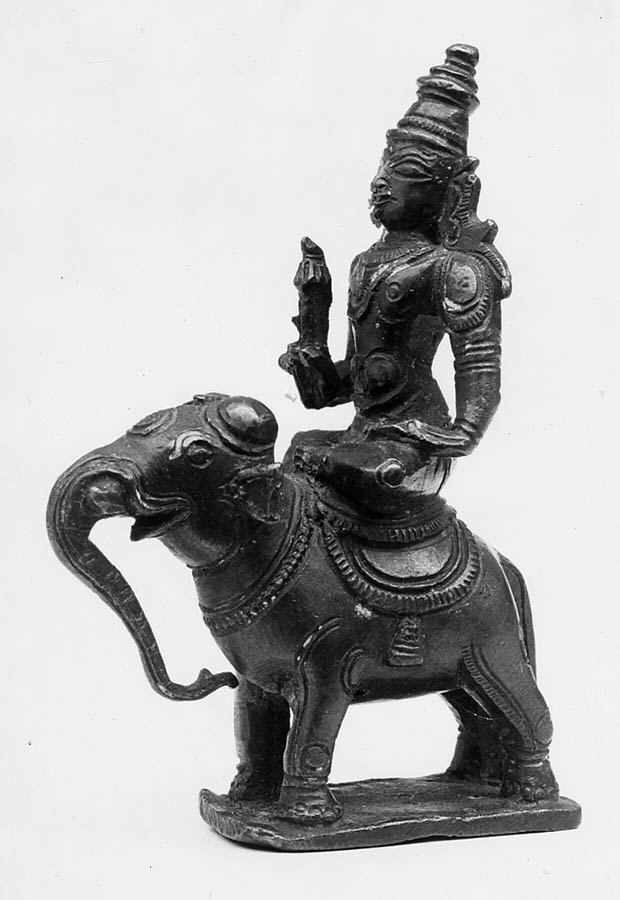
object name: portable idol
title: Guardian (Ainar)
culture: indian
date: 1701-1800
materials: brass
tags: men,elephants